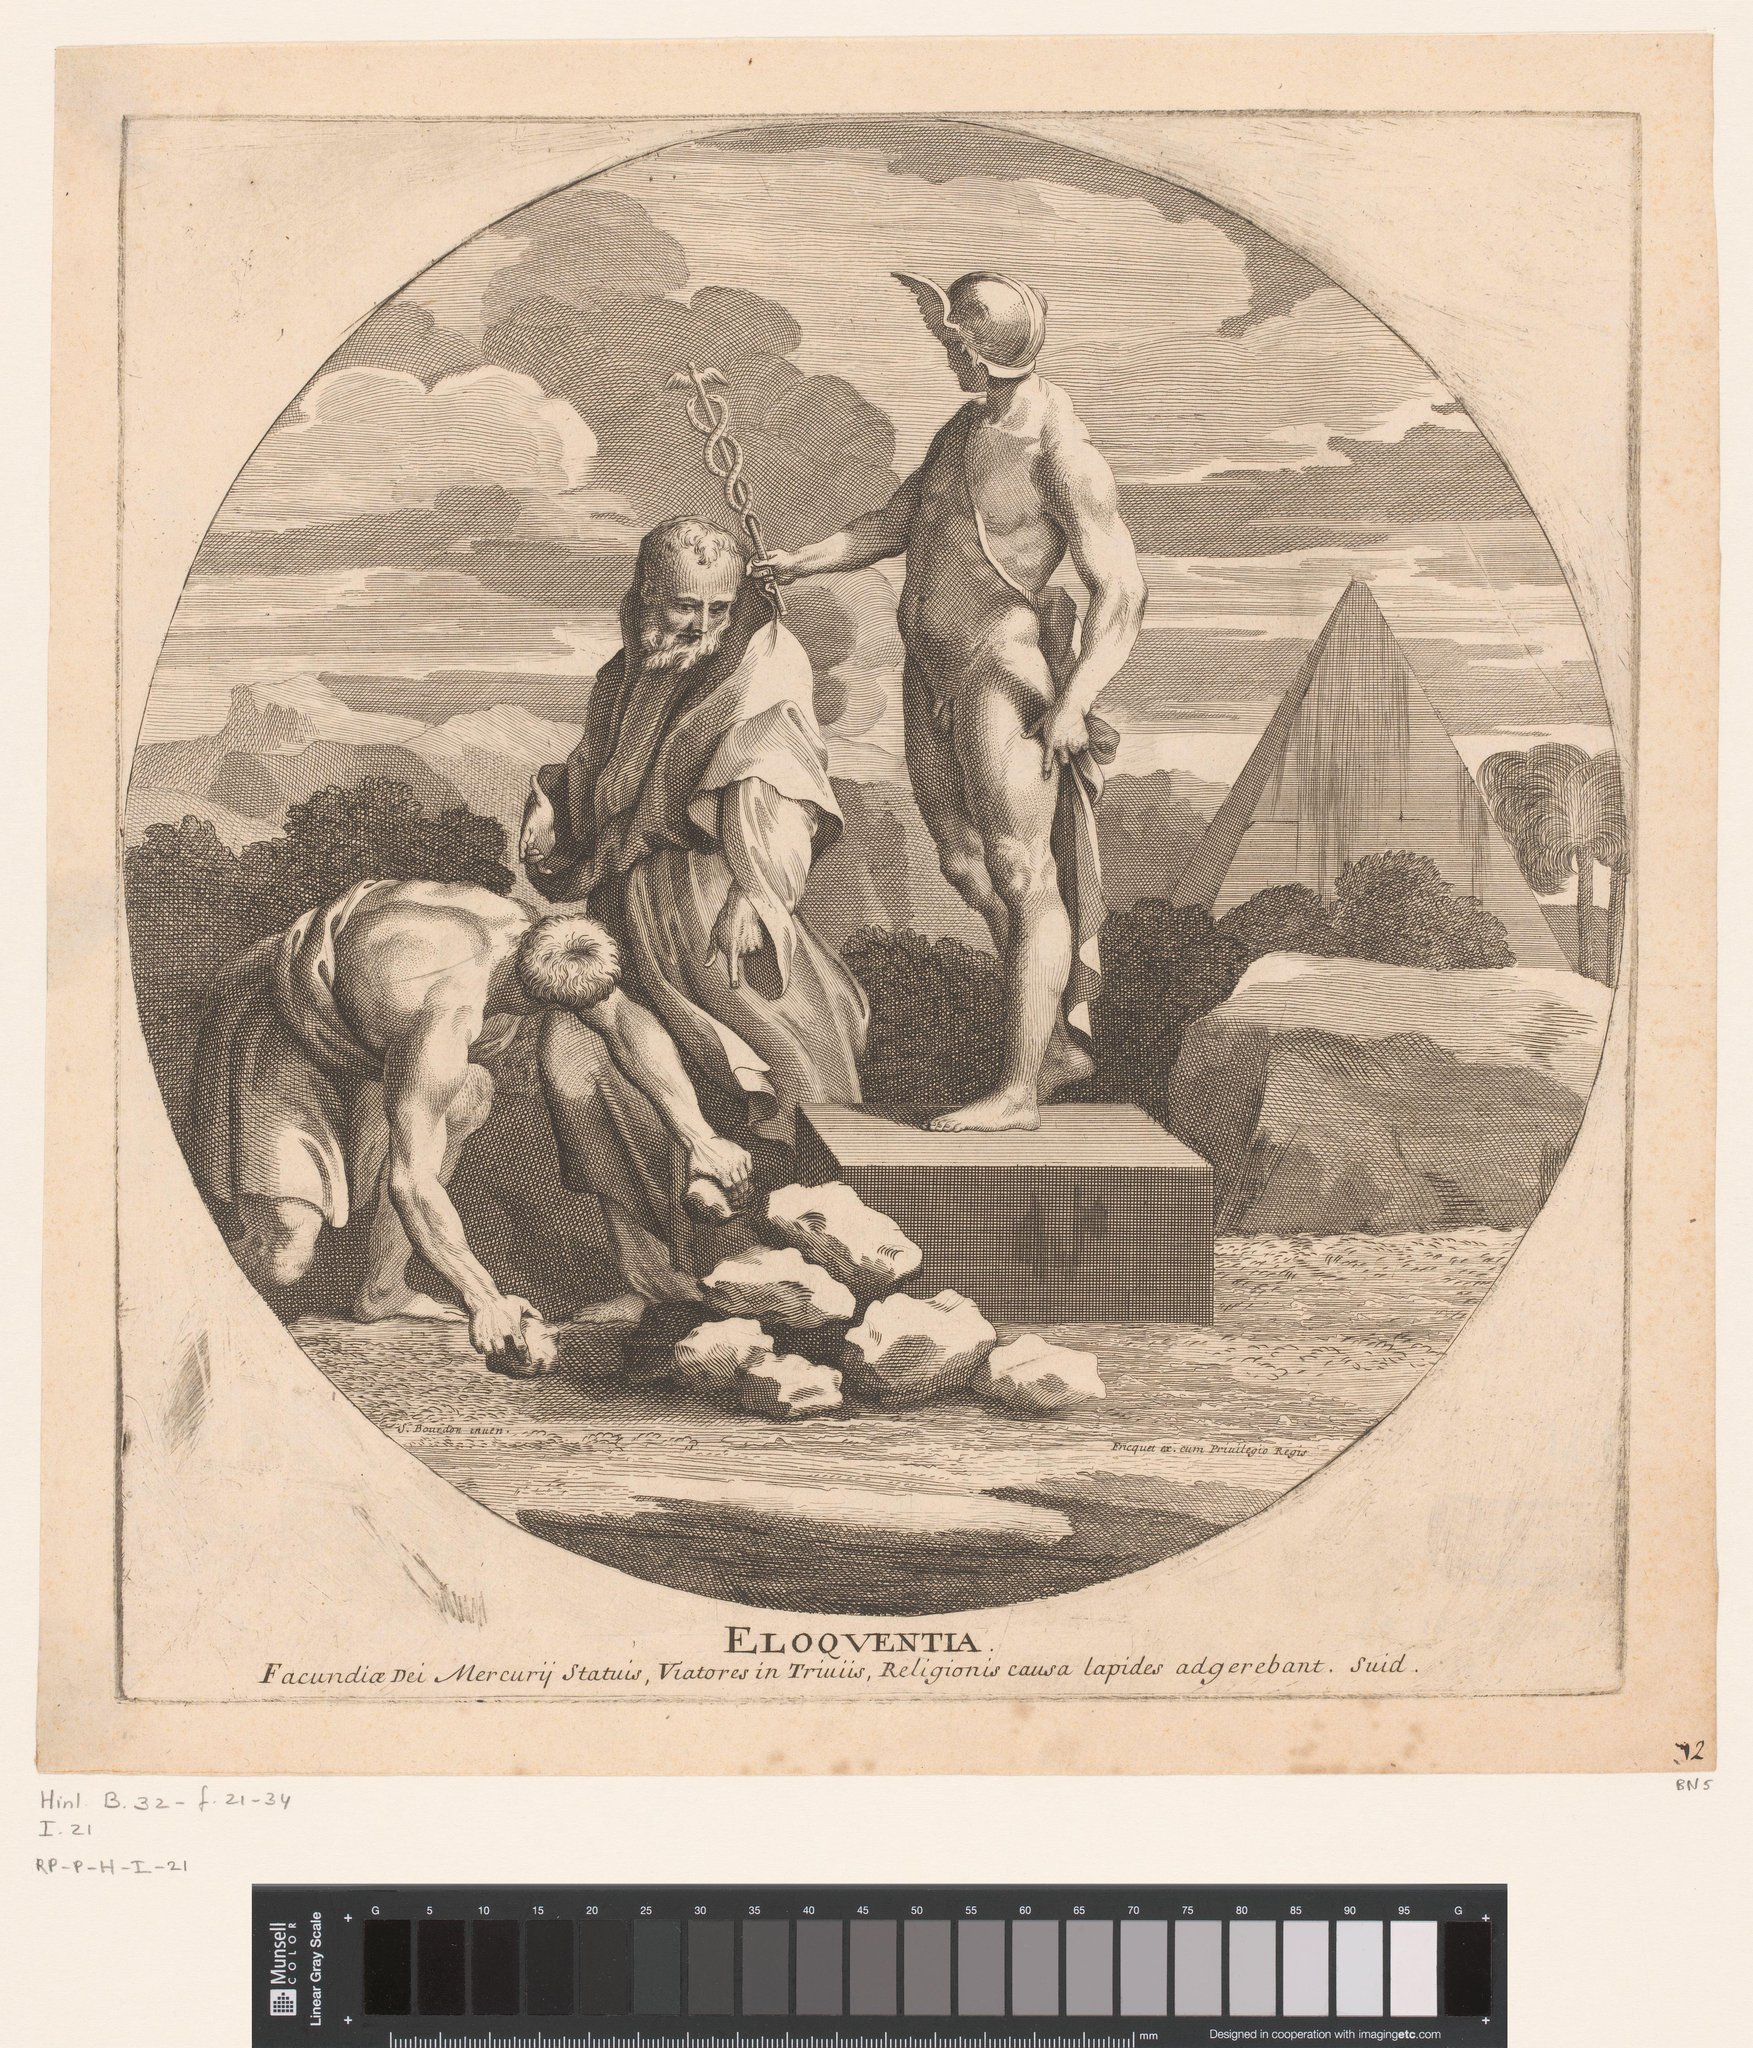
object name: print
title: Les Vertus et les Arts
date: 1663-1716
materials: paper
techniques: engraving, etching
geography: paris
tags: 'rhetorica', 'eloquentia' (~ trivium); 'rettorica' (ripa), specific aspects, allegorical aspects of mercury; mercury as patron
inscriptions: collector's mark: Lugt 11, number: ‘12’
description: Maakt deel uit van een veertiendelige serie opgedeeld in twee reeksen, met als onderwerp de zeven vrije kunsten en deugden naar schilderijen door Sébastien Bourdon. De schilderijen werden in 1663 vervaardigd voor de Grande Galerie van het Hôtel de Bretonvilliers te Parijs.